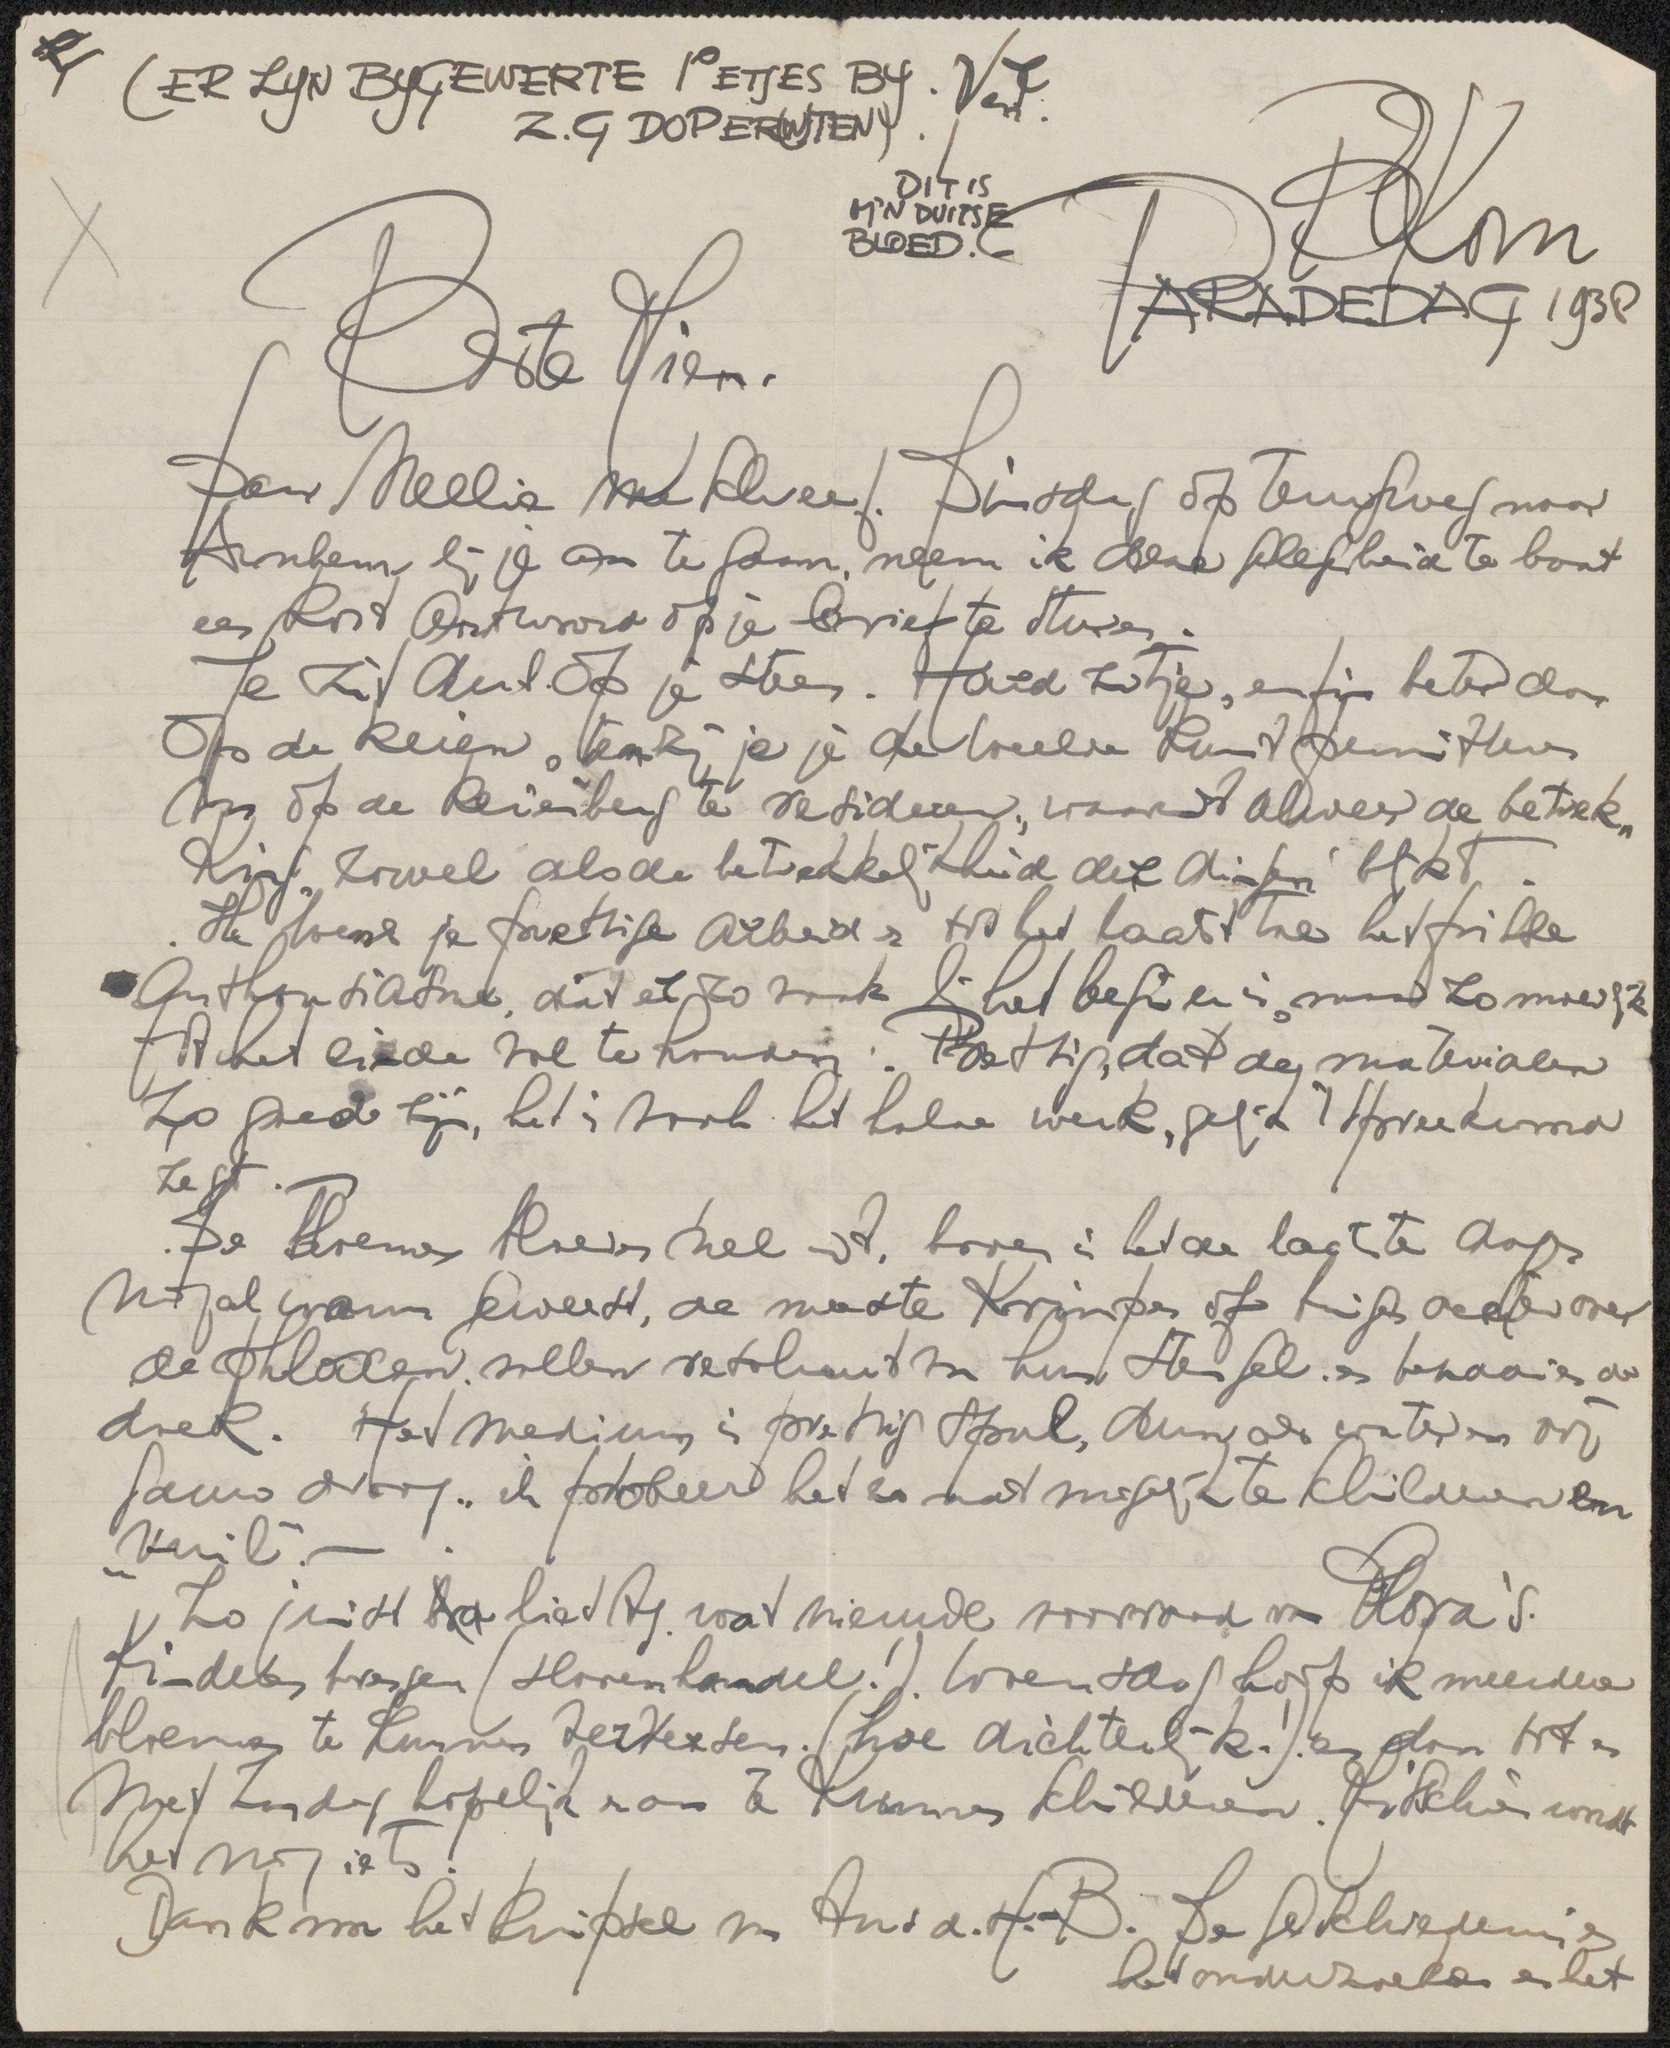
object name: letter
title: Brief aan Mien Cambier van Nooten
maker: dick ket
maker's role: draughtsman, print maker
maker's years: 1902-1940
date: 1938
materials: ink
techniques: pen, writing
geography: bennekom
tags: painter, mien cambier van nooten, united states of america, print maker, draughtsman, jo spier, dollmaker, textile artist, nelly johanna hagelen-schilt, painting (including book-illumination, miniature-painting), historical persons (portraits and scenes from the life)